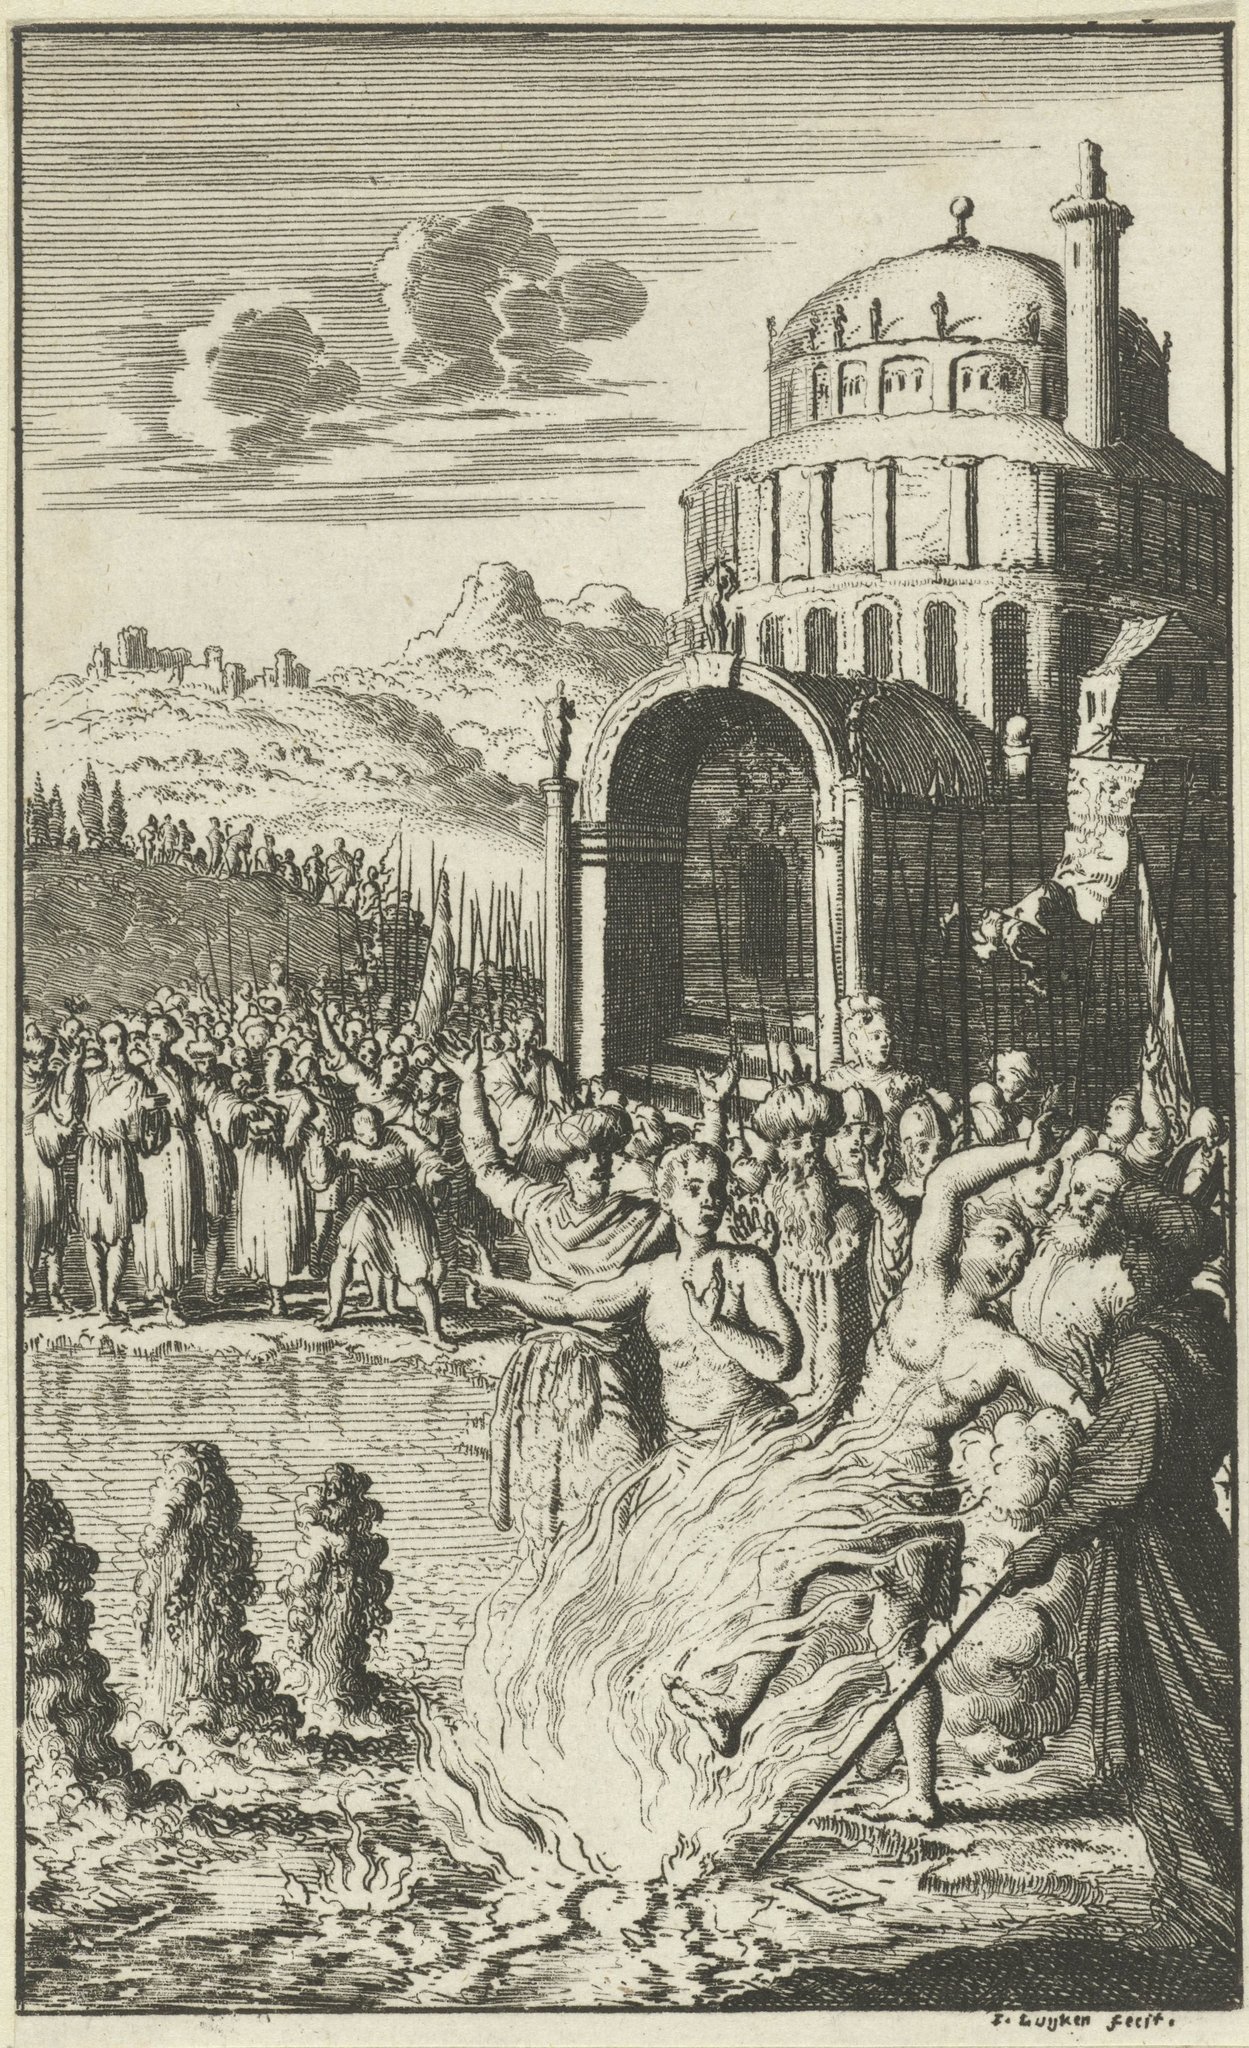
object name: book illustration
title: Alcidamis gedood door vlammen die uit het water opstijgen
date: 1681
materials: paper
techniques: etching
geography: amsterdam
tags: violent death ~ fire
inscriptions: collector's mark: Lugt 240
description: Illustratie opgenomen in het tweede deel van: Barclay, John. D'Argenis, 2 delen. Amsterdam: Jan Claesz ten Hoorn, 1680-1681.